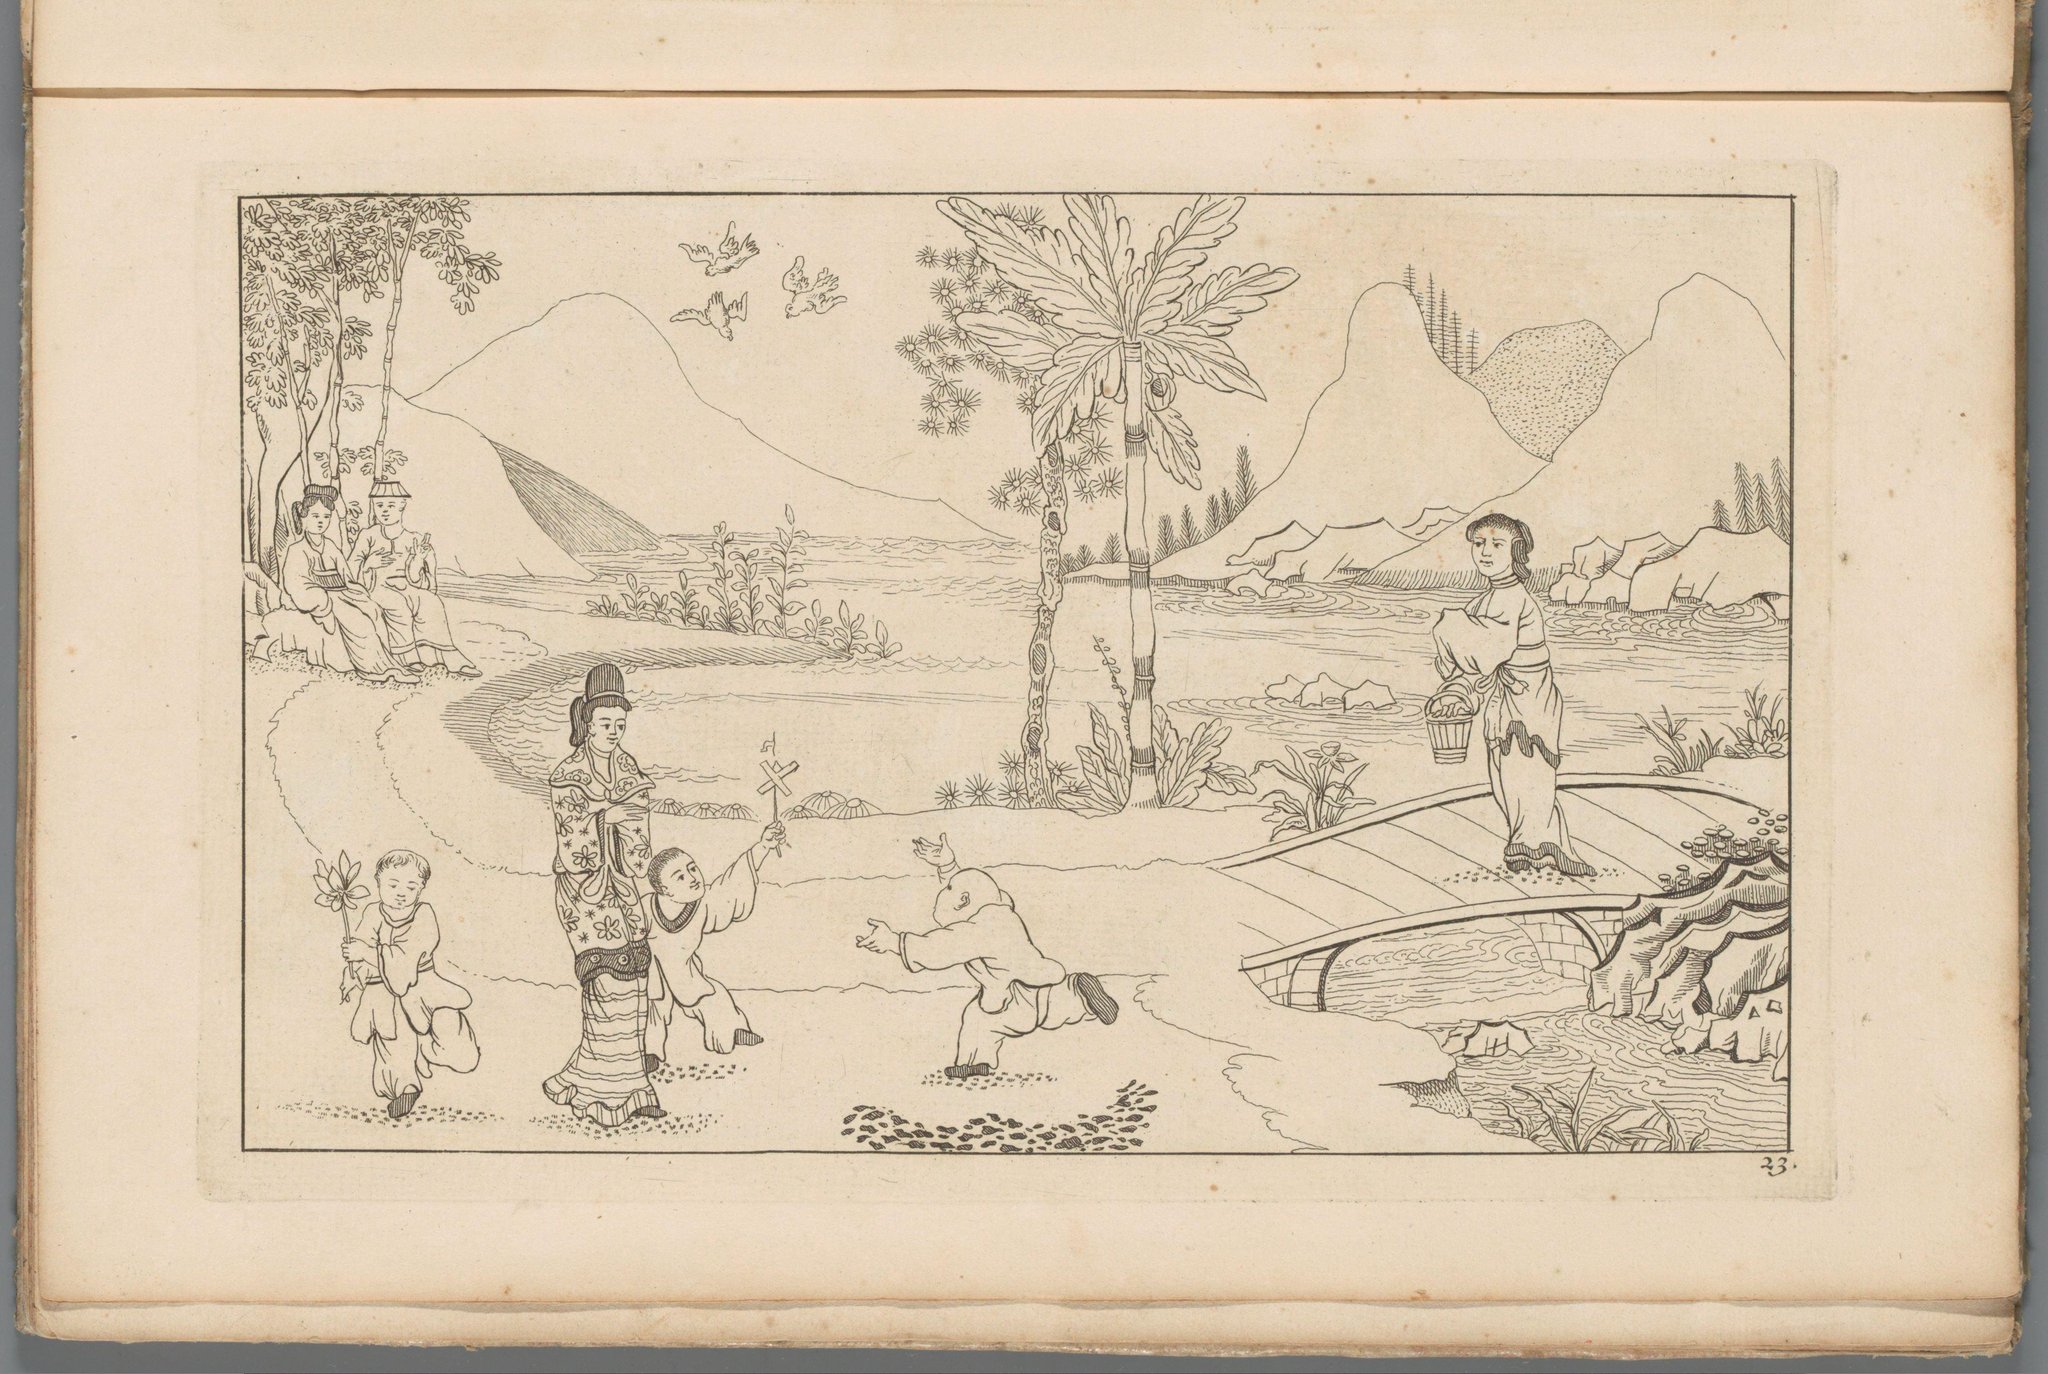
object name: ornament print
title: Nieuwe geinventeerde Sineesen met groote moeyte geteekent en in 't Ligt gegeven, door P. Schenk Jun (...), tweede deel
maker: pieter schenk (ii)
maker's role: draughtsman, print maker, publisher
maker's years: 1693-1775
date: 1727-1775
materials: paper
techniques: etching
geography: amsterdam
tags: children's games and plays, chinese, landscapes in the temperate zone, landscape with bridge, viaduct or aqueduct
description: Chinees landschap met een vrouw en drie spelende kinderen. Rechts een vrouw op een brug. Prent maakt deel uit van een album.